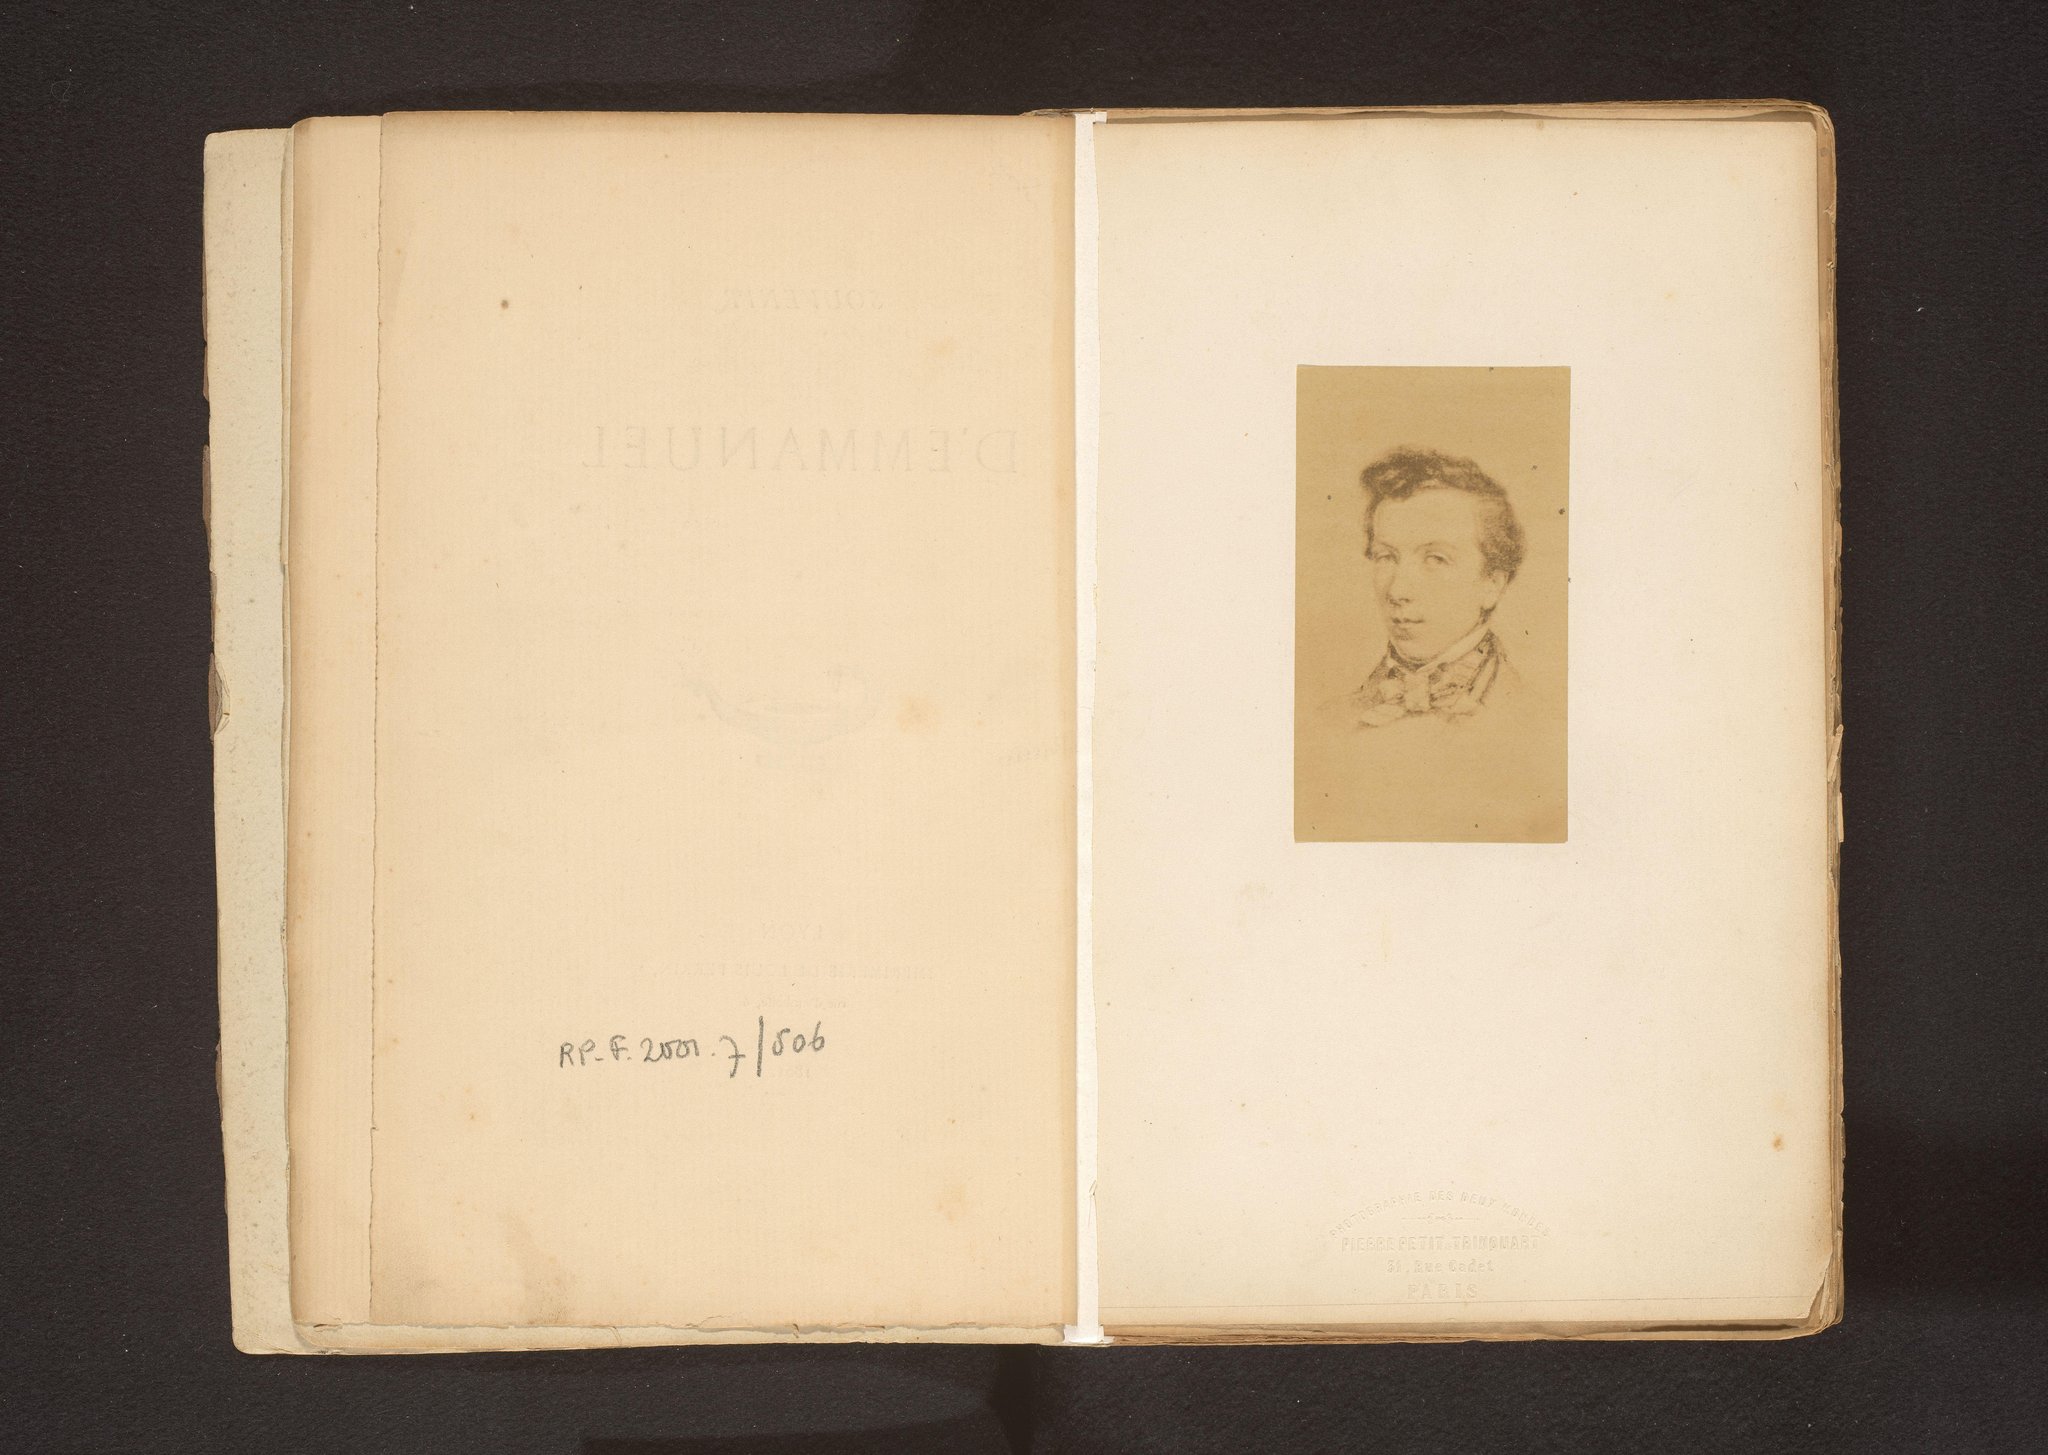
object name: page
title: Fotoreproductie van een portret van vermoedelijk Emmanuel Garnier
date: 1850-1861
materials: photographic support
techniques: albumen print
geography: paris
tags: youth, adolescent